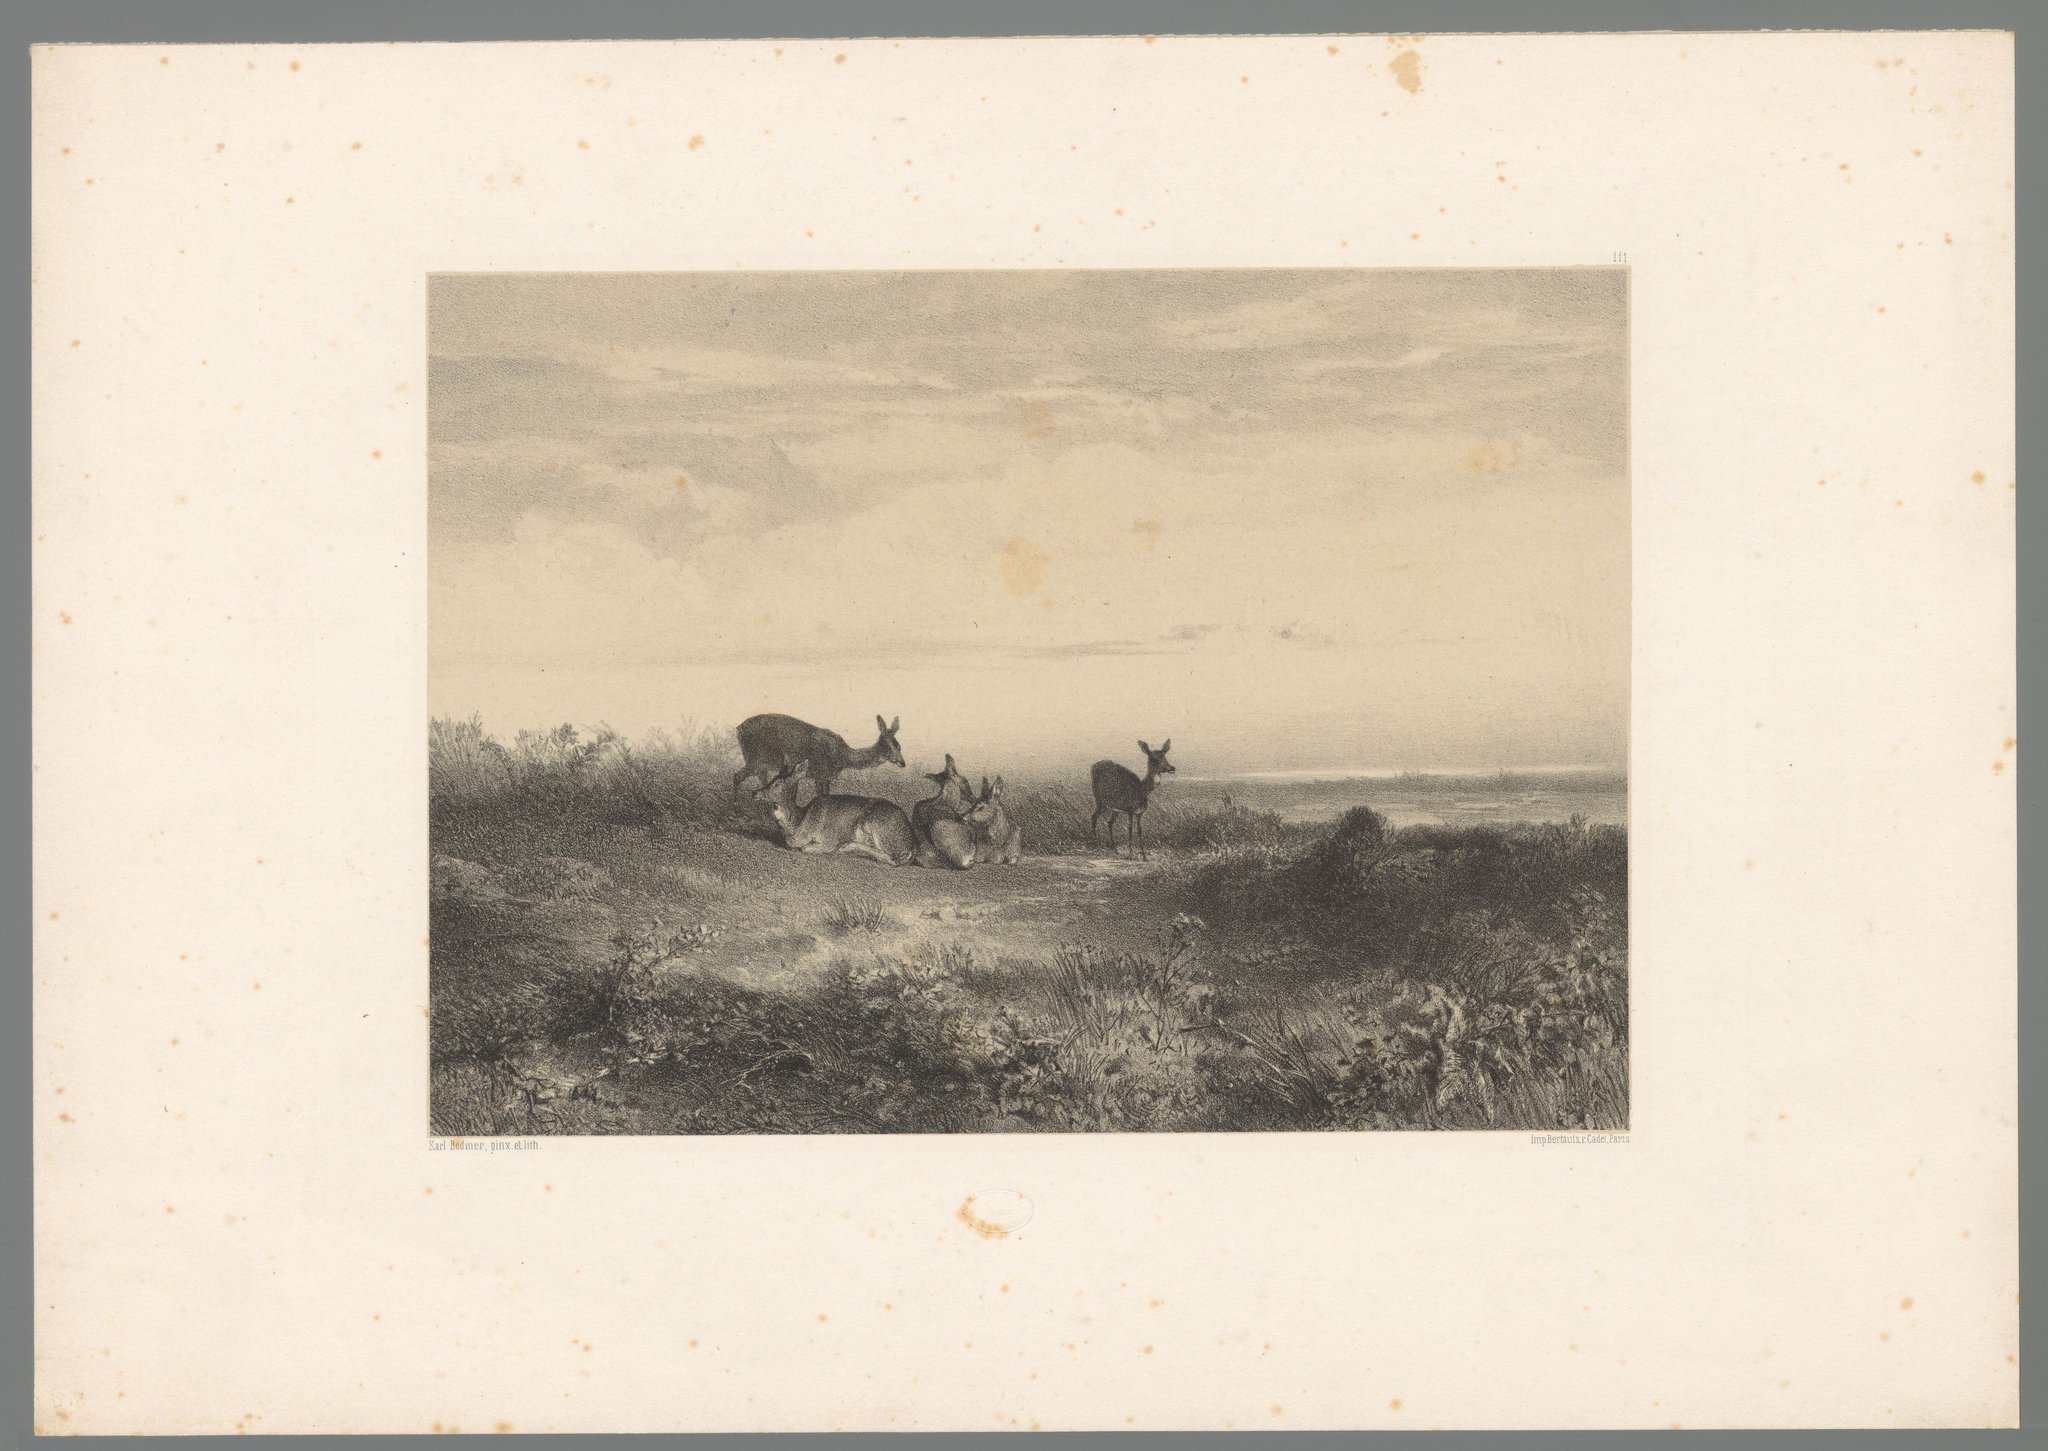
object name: print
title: Oude en hedendaagse kunstenaars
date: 1854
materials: paper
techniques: lithograph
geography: paris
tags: hoofed animals: deer, meadow, pasture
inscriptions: check stamp: Lugt 36a, collector's mark: Lugt 2228